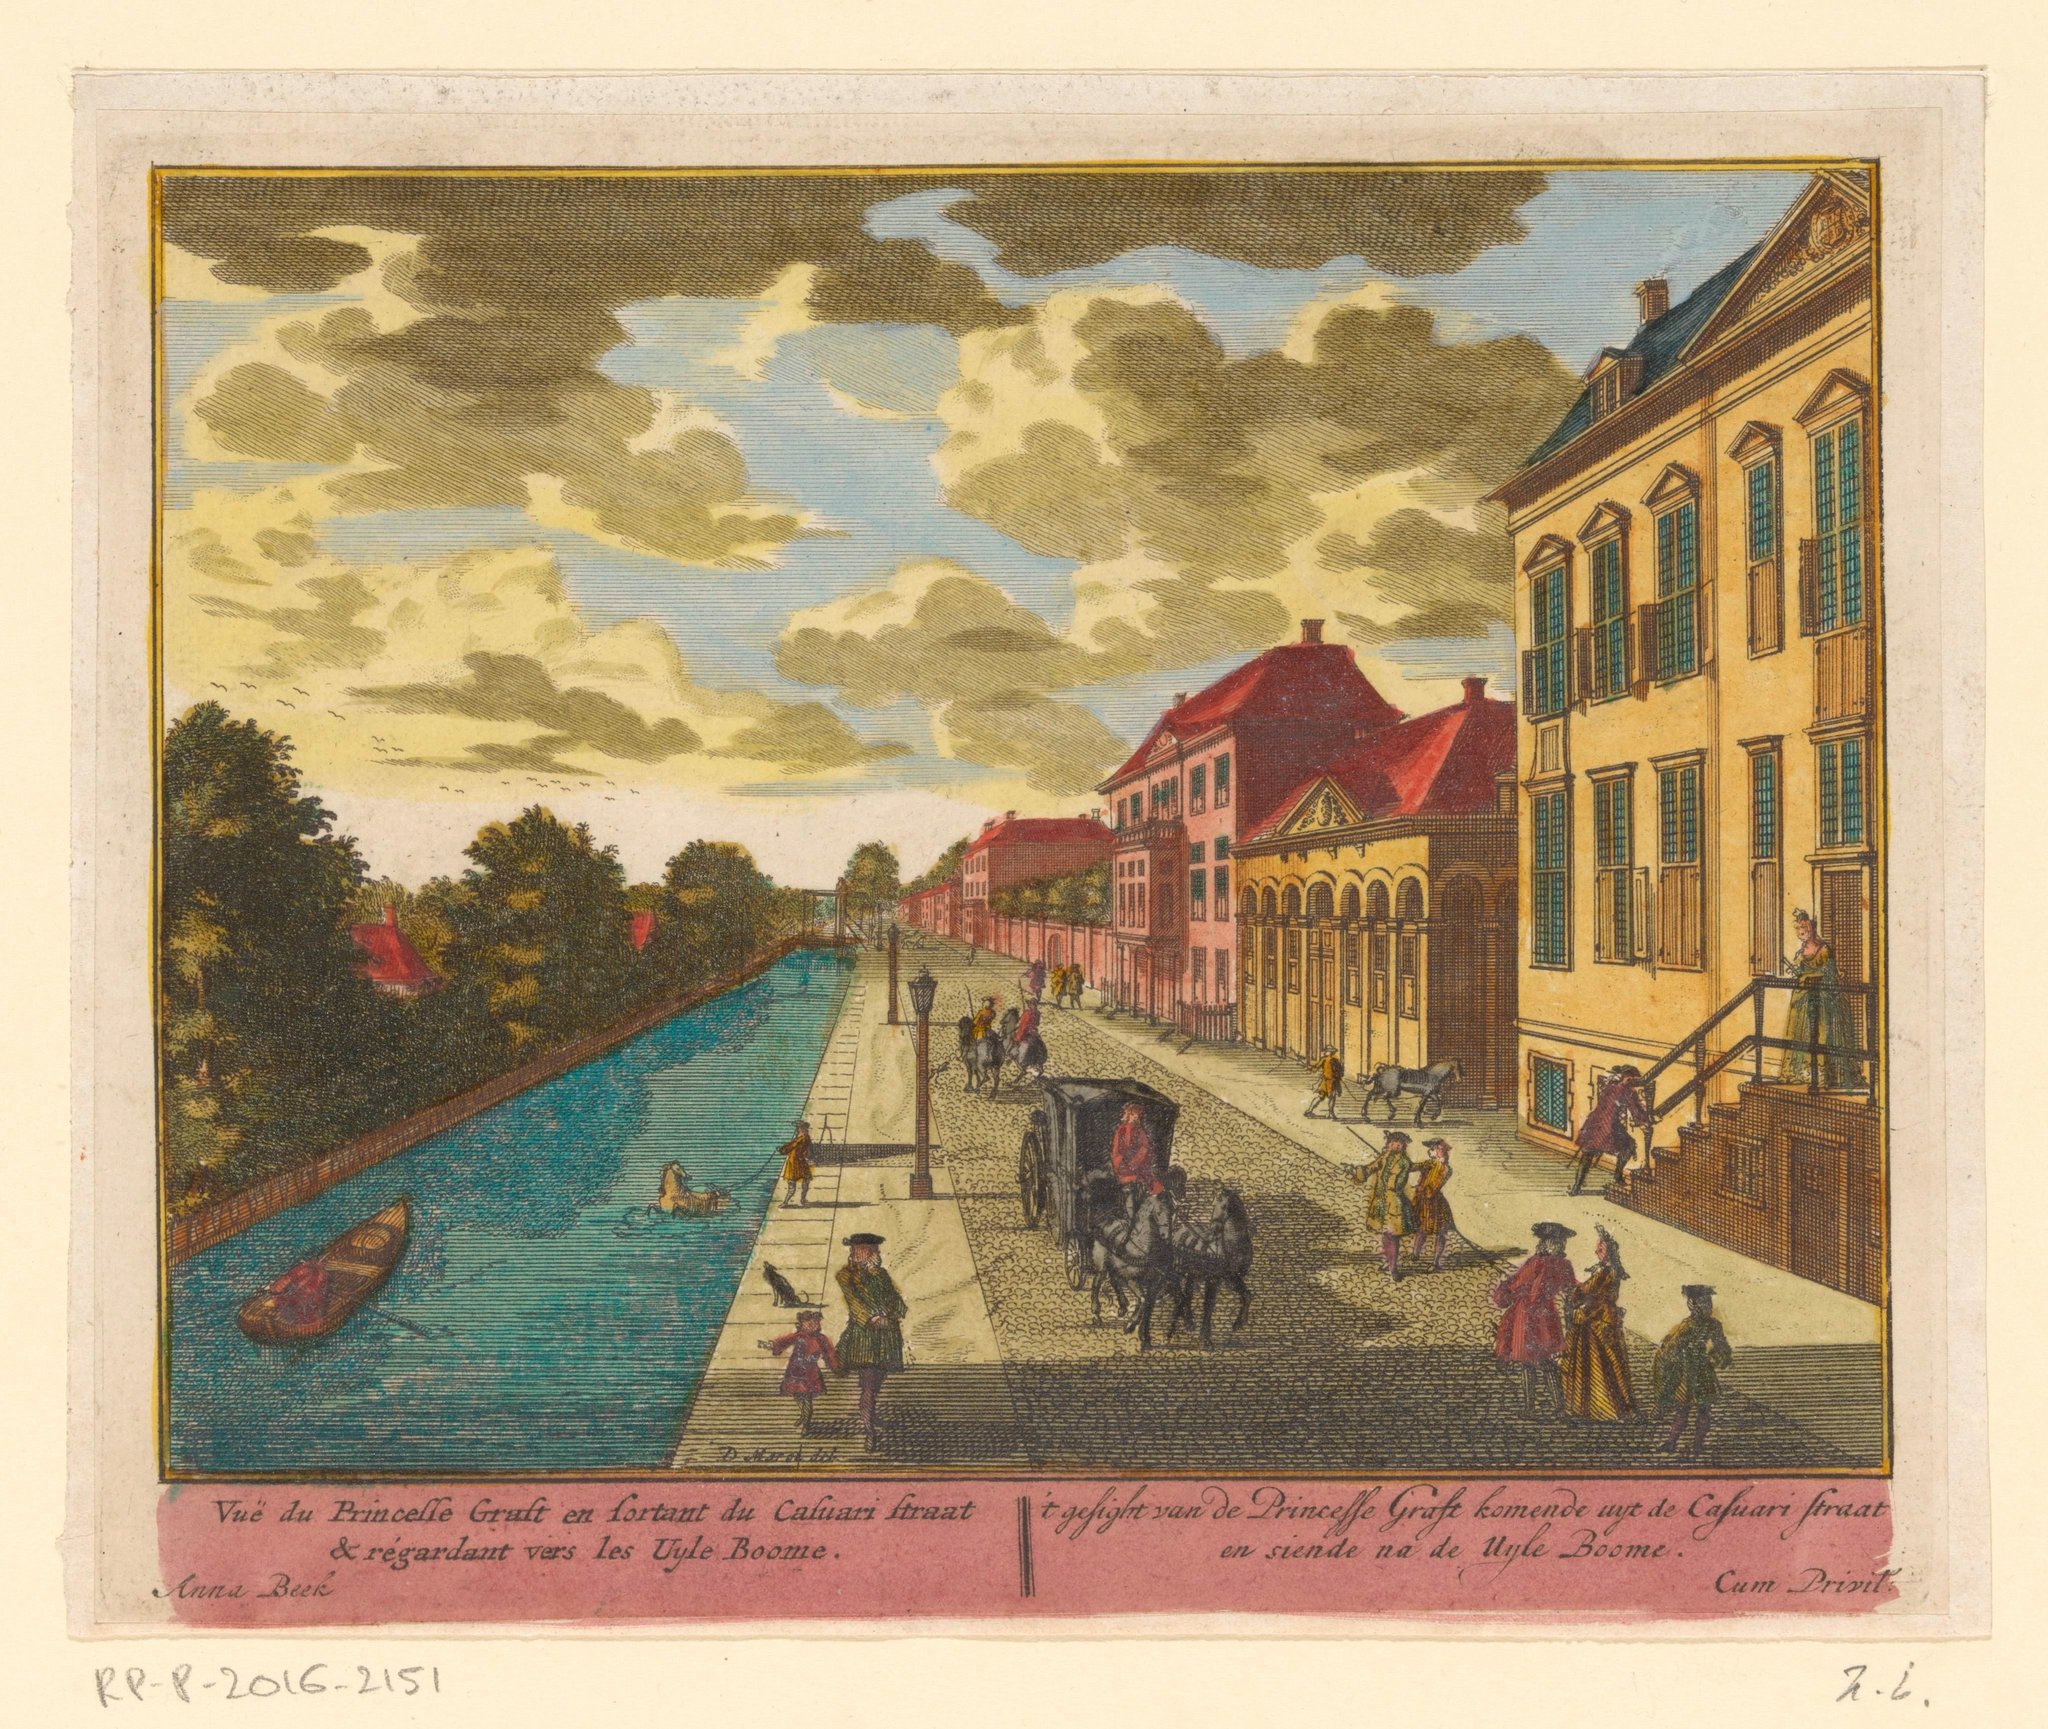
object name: print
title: 't Gesight van de Princesse Graft komende uyt de Casuari straat en siende na de Uyle Boome / Vuë du Princesse Graft en sortant du Casuari straat & régardant vers les Uyle Boome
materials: paper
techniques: engraving, etching, hand coloring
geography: the hague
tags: canals, waters (in city), bridge, public gardens, park, street (+ city(-scape) with figures, staffage)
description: Mogelijk uitgegeven als onderdeel van een serie van veertien gezichten in Den Haag. Zie ook RP-P-AO-12-34A, RP-P-AO-12-118-1, RP-P-AO-12-118-2, RP-P-AO-12-118-3, RP-P-AO-12-118-4, RP-P-AO-12-118-5, RP-P-AO-12-118-6, RP-P-AO-12-118-7, RP-P-AO-12-118-8, RP-P-AO-12-118-9, RP-P-AO-12-118-10, RP-P-AO-12-118-11, RP-P-AO-12-118-12, RP-P-AO-12-118-13, RP-P-2016-2145, RP-P-2016-2146, RP-P-2016-2147, RP-P-2016-2148, RP-P-2016-2149 en RP-P-2016-2150.